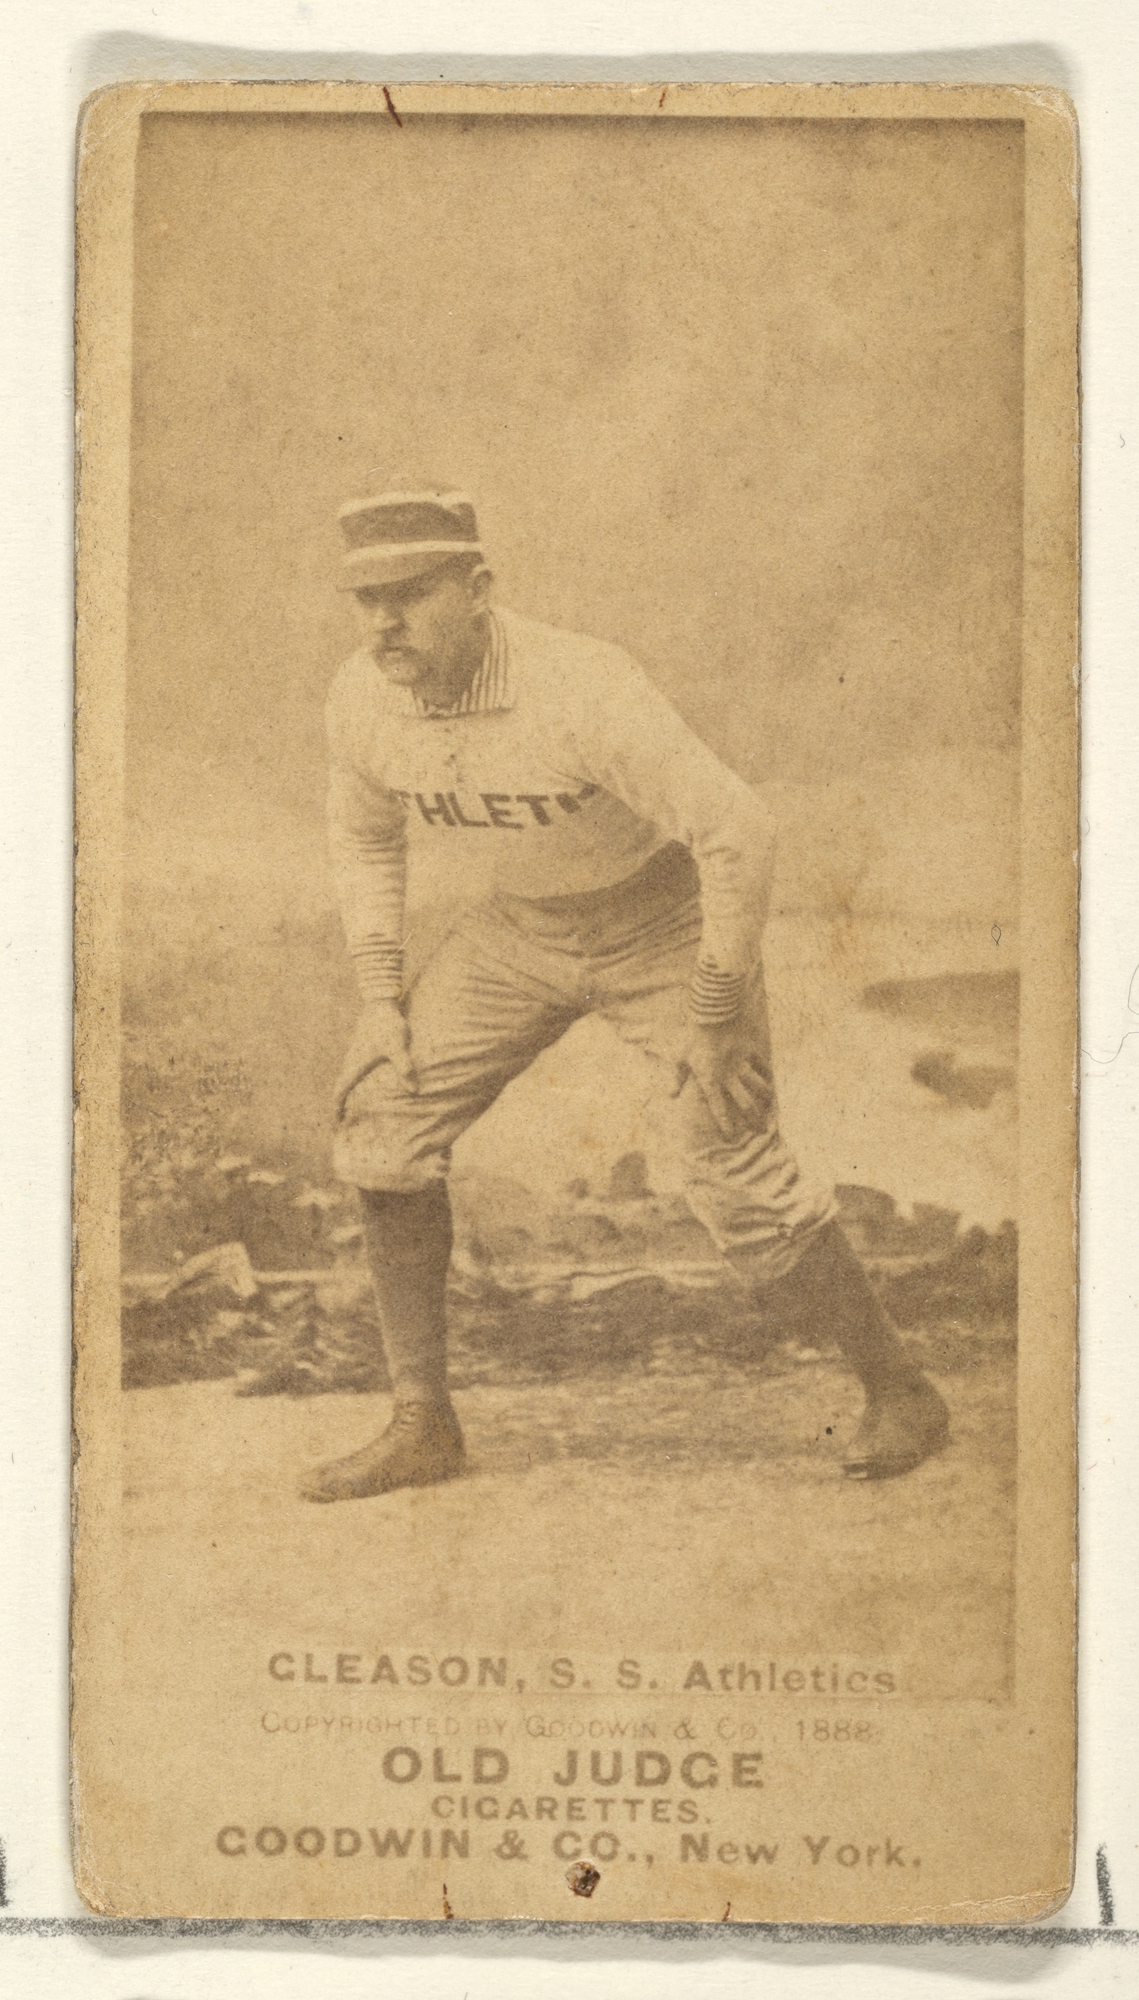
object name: baseball card, photograph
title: Gleason, Shortstop, Philadelphia Athletics, from the Old Judge series (N172) for Old Judge Cigarettes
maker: goodwin & company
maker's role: publisher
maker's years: 1850-1950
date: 1888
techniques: albumen silver print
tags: men,portraits,baseball,athletes